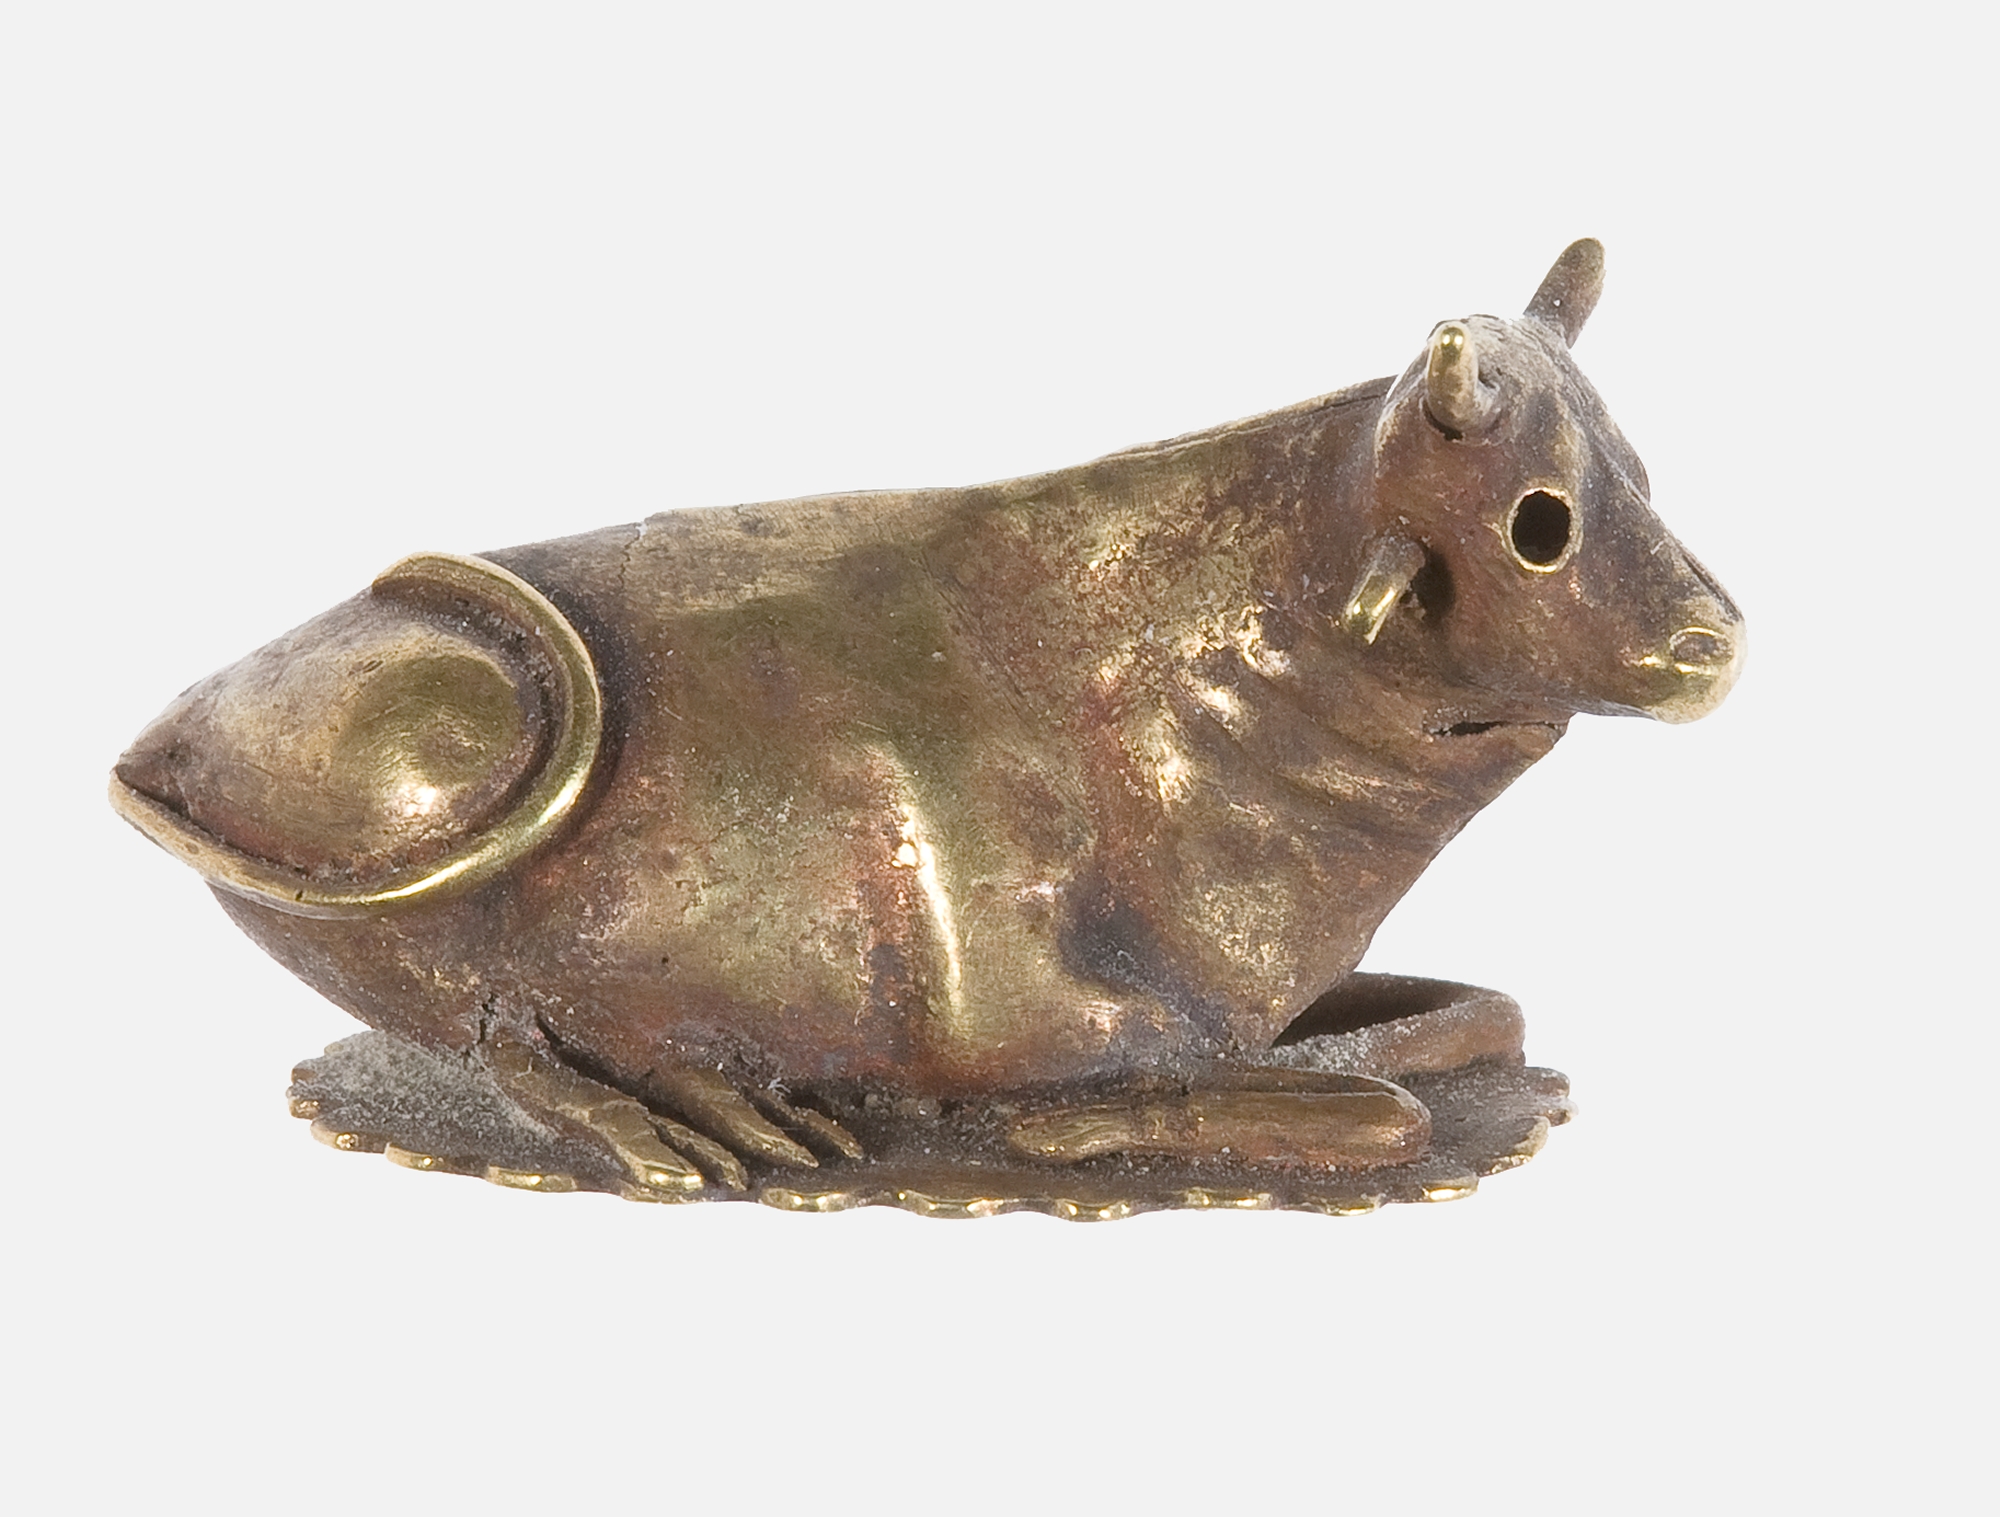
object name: figurine, bovine recumbent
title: Resting bovine figurine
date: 664-380 BCE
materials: gold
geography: egypt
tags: animals